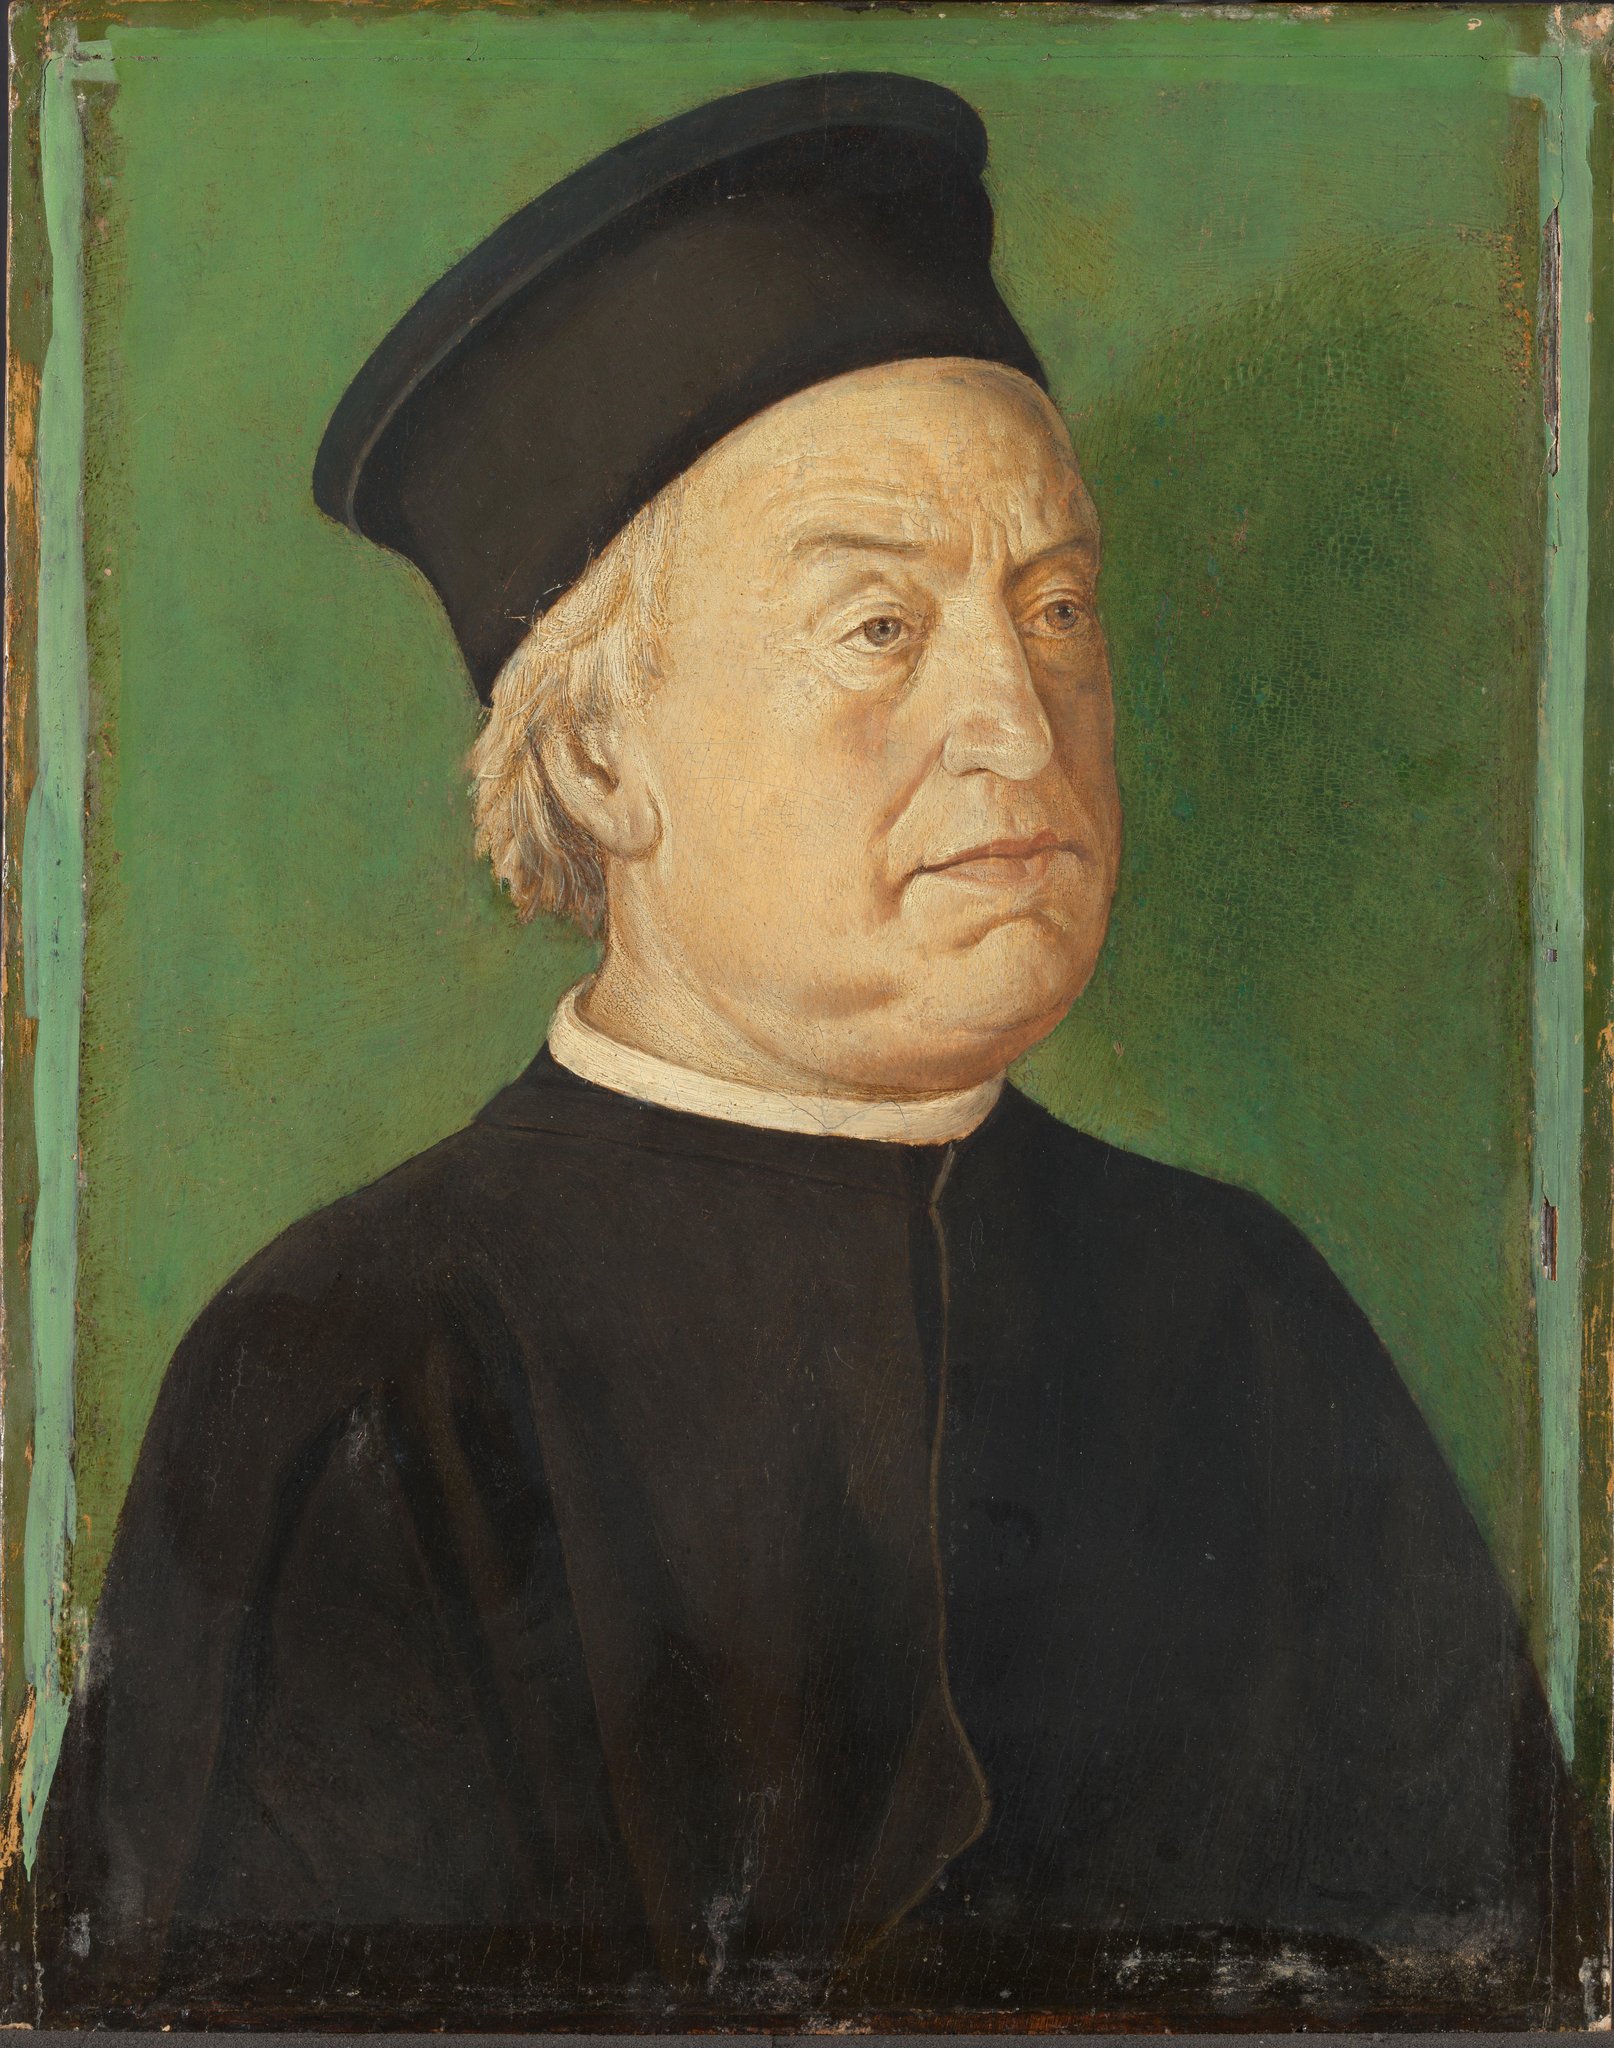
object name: painting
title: Portret van een man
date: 1910-1935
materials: oil, panel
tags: anonymous historical person portrayed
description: Portret van een man. Buste van een geleerde, naar rechts, met een zwarte baret op het hoofd. Vervalsing in de stijl van Melozzo da Forli.